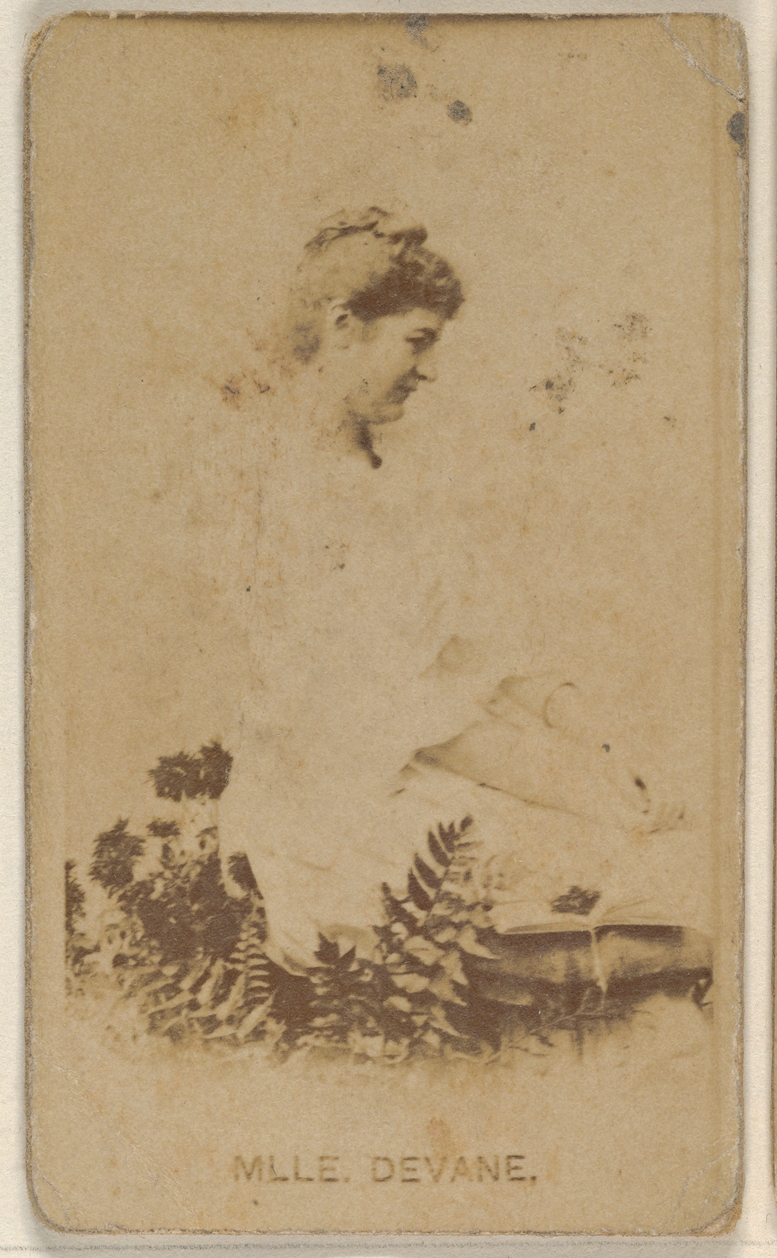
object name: photograph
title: Mlle. Devane, from the Actors and Actresses series (N45, Type 8) for Virginia Brights Cigarettes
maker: allen & ginter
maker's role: publisher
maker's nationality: american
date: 1888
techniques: albumen silver print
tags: portraits,women,actresses